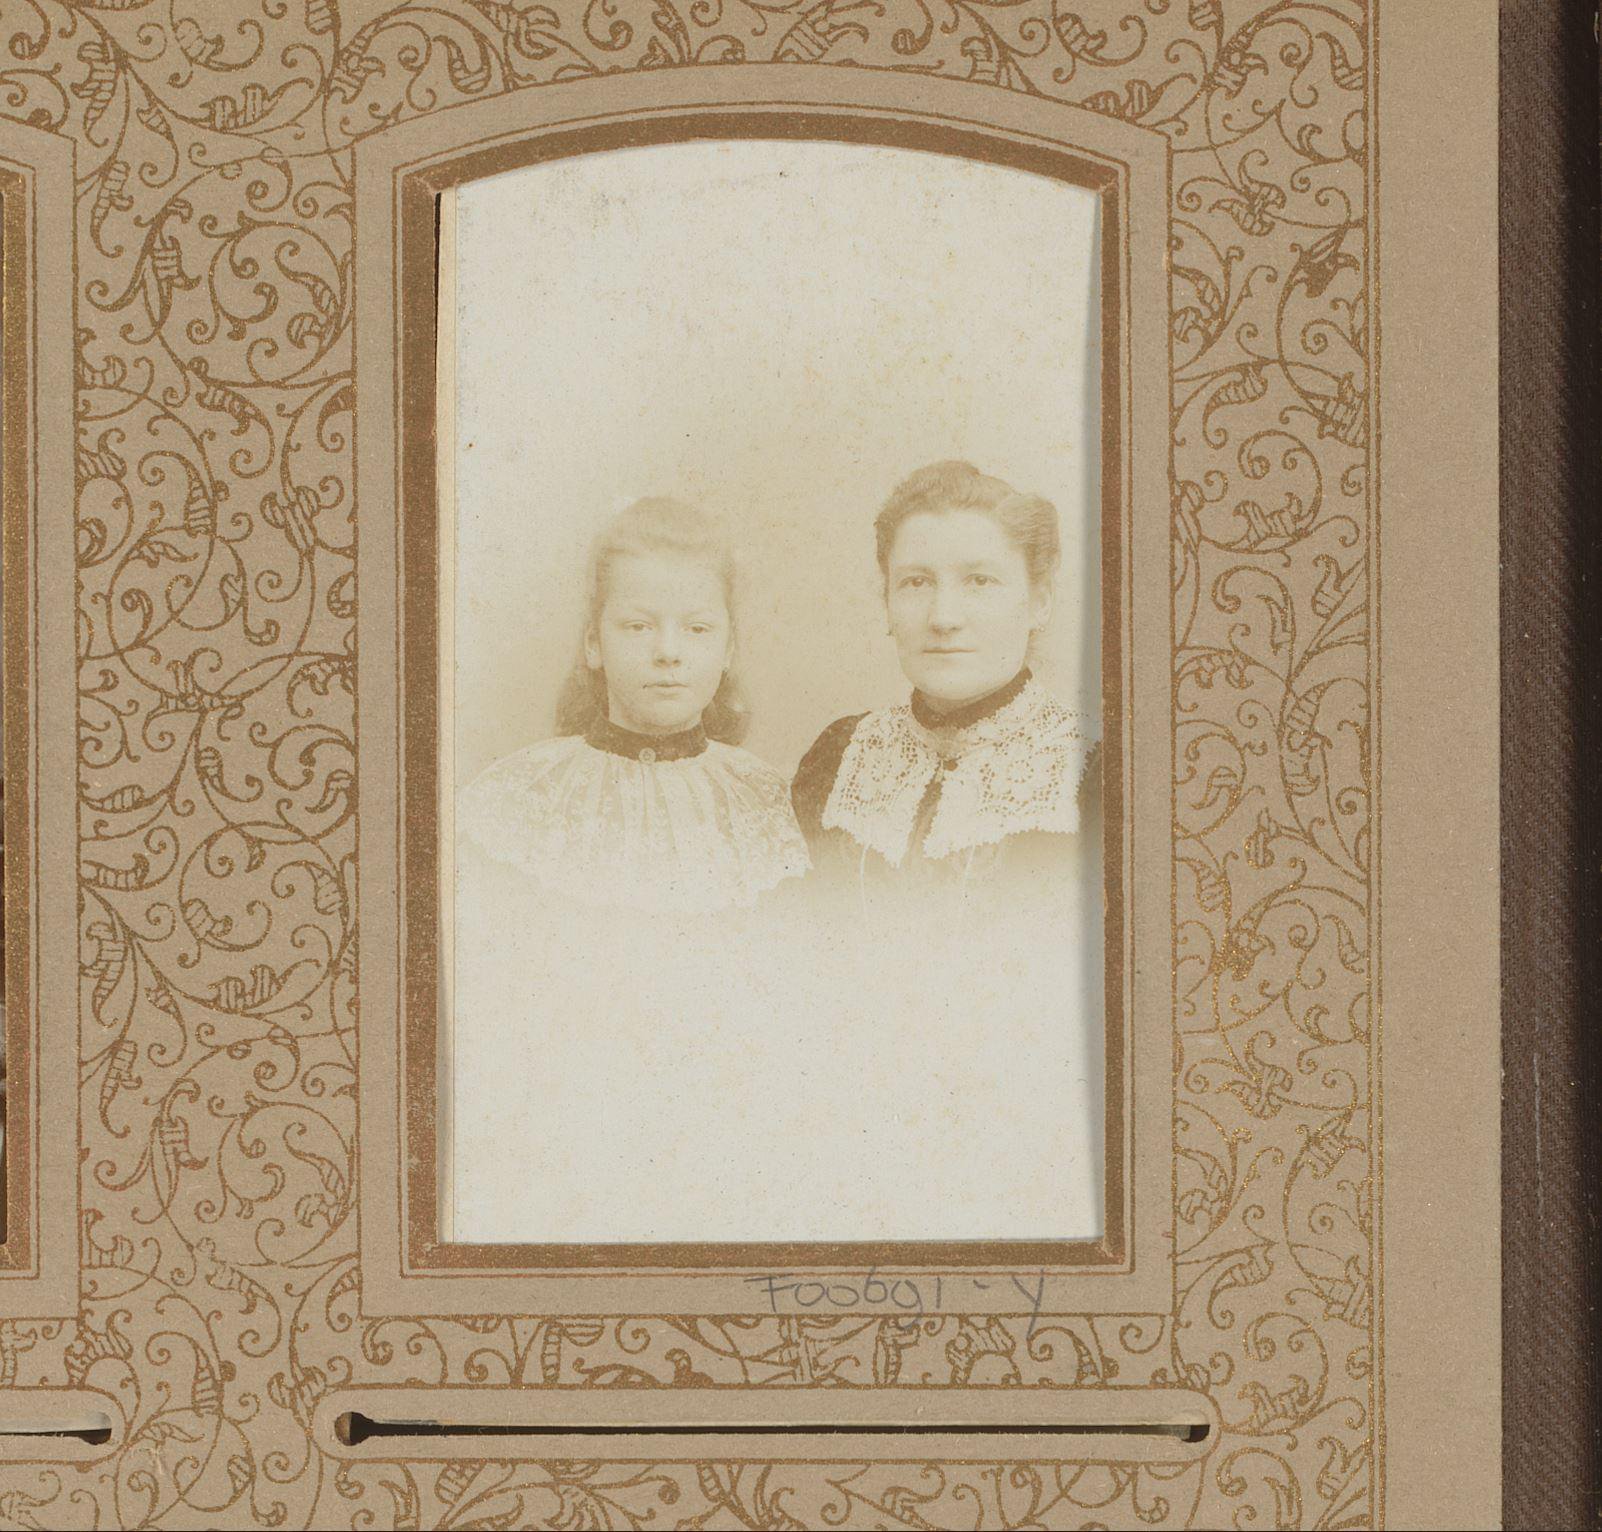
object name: photograph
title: Portret van een meisje in witte jurk met hoed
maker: Anonymous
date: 1900-1920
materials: cardboard, photographic support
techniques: gelatin silver print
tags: girl (child between toddler and youth)